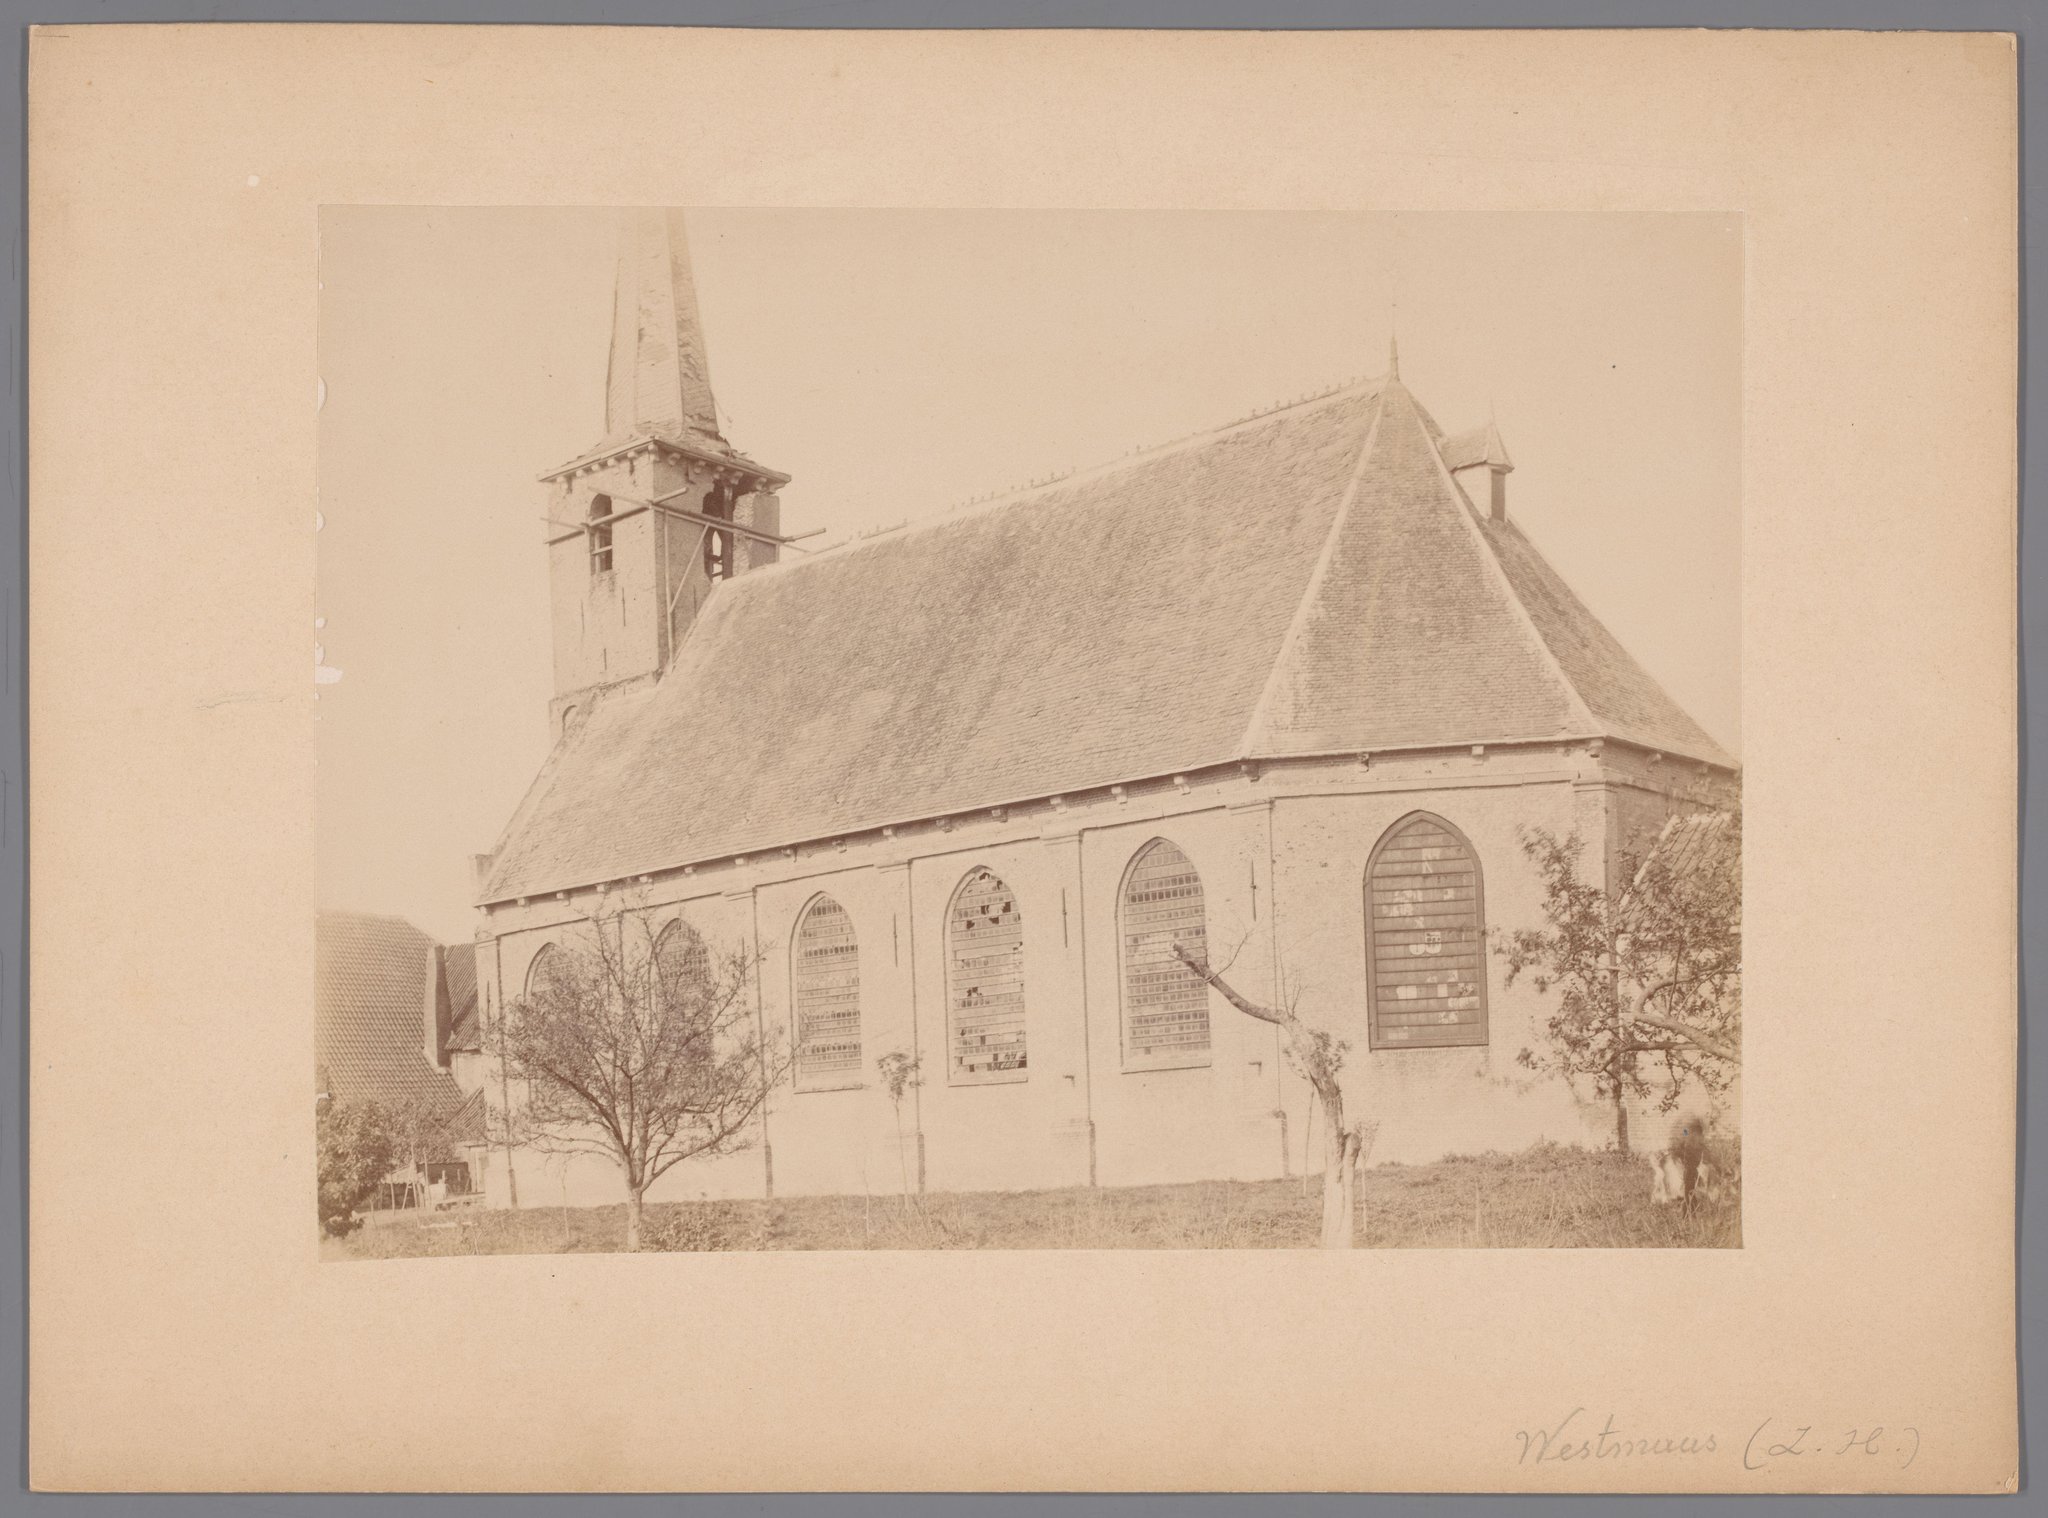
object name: photograph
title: Gezicht op de Hervormde Kerk te Westmaas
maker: anoniem (monumentenzorg)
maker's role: fotograaf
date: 1890-1920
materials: cardboard, photographic support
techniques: albumen print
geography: westmaas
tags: church (exterior)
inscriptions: annotation: ‘Westmaas Z.H./ N.H. Kerk’, annotation: ‘Westmaas (Z.H.)’